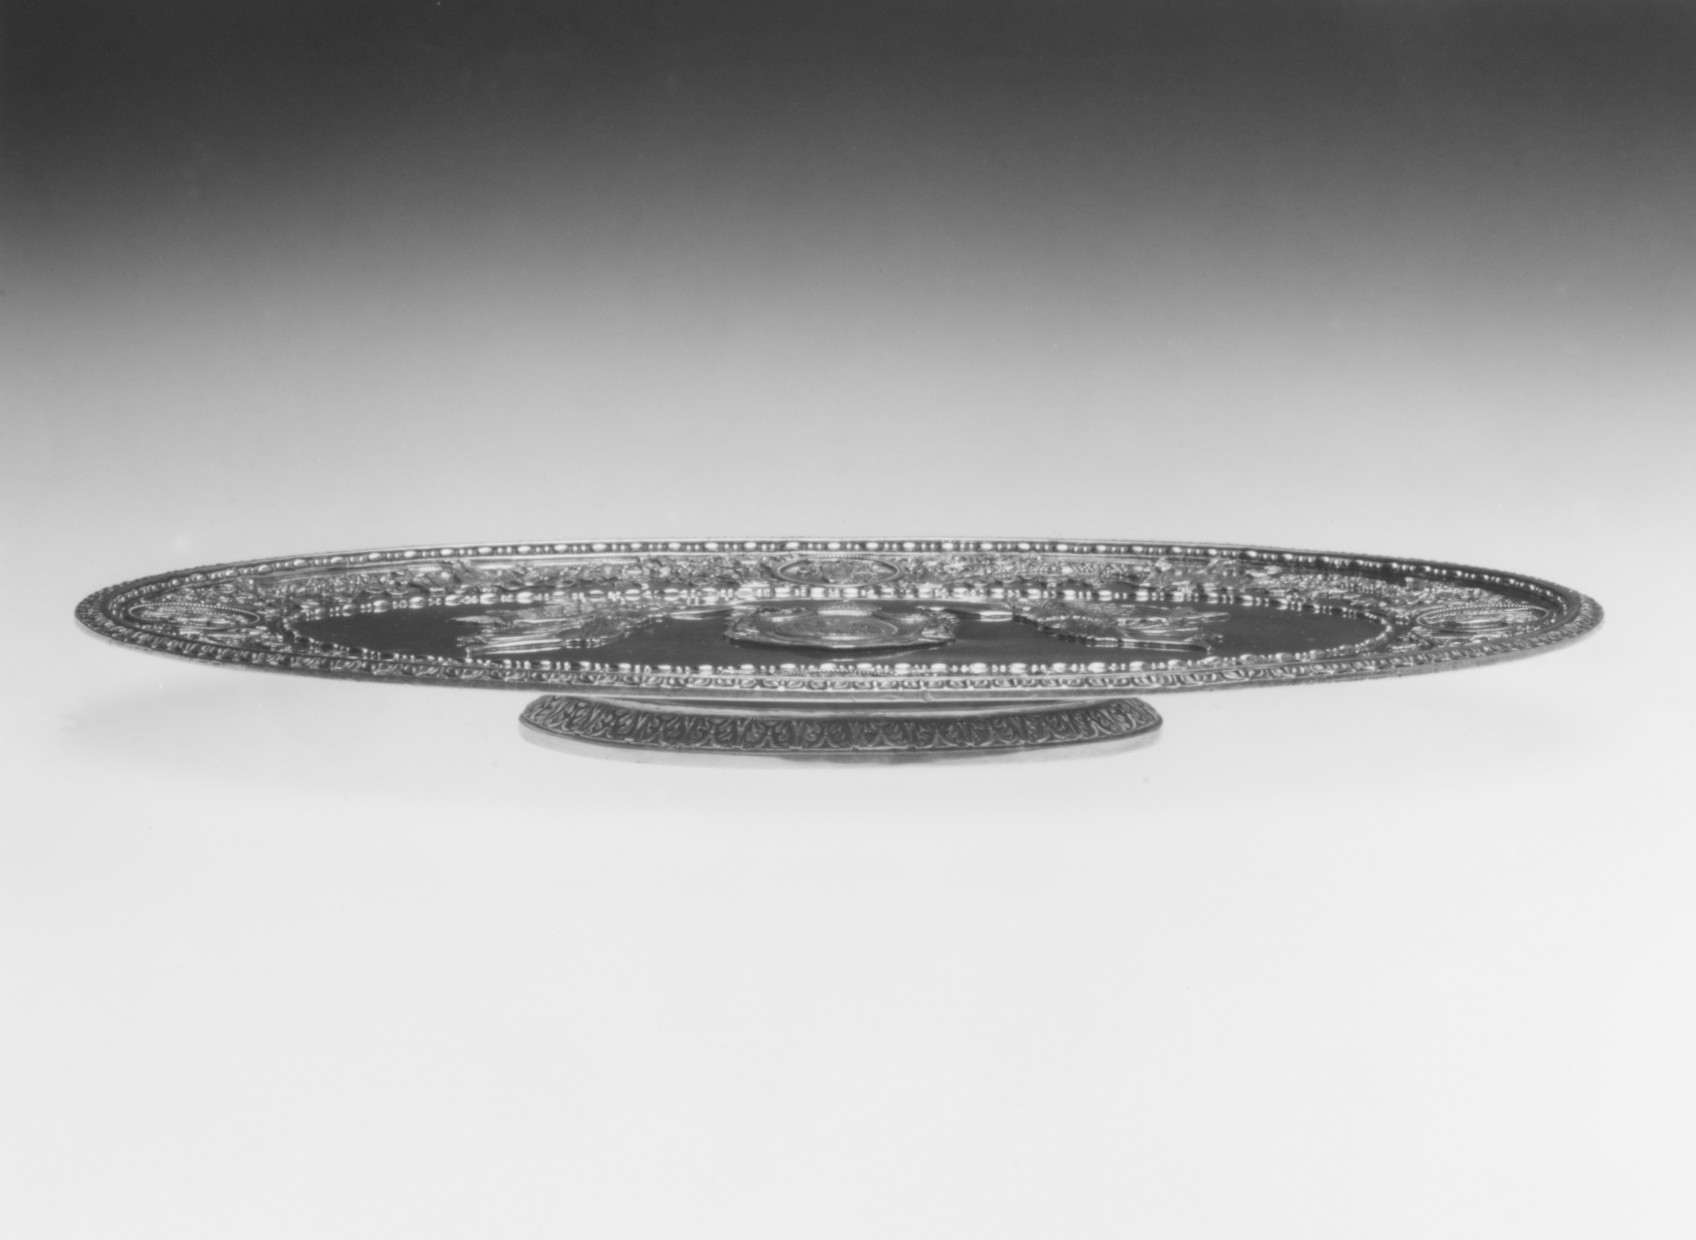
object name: salver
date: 1801-1900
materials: silver gilt